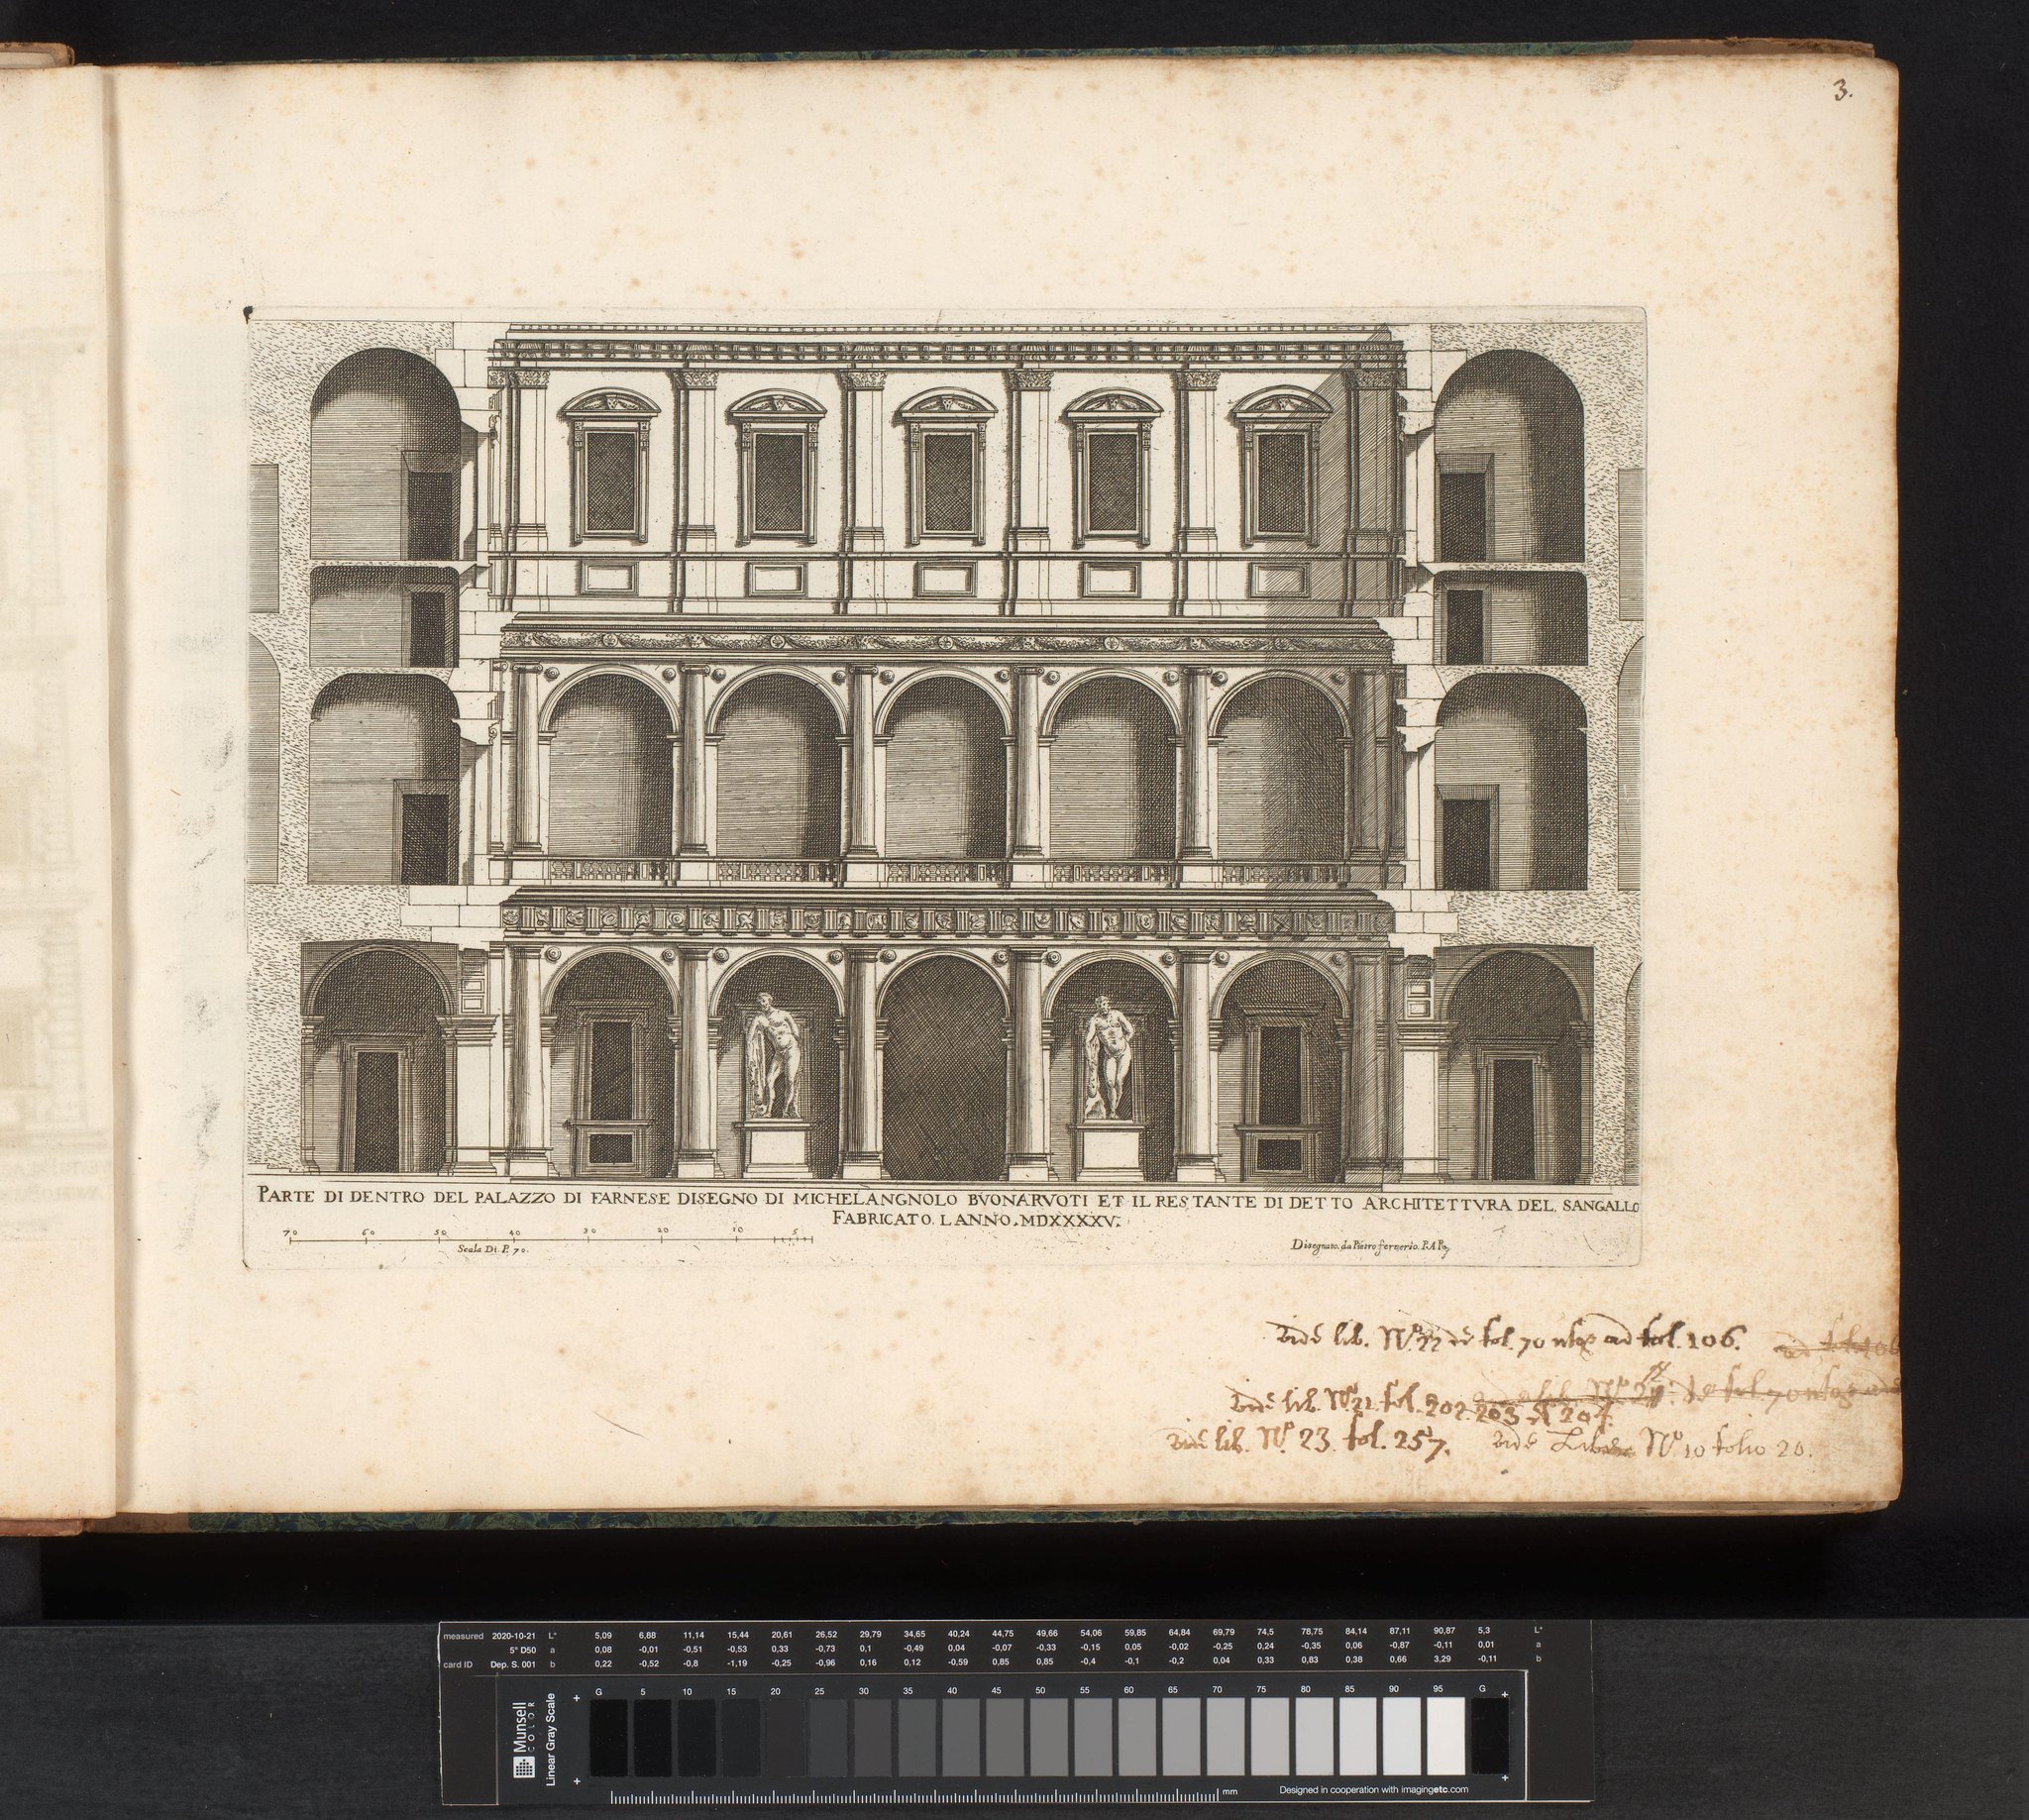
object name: album leaf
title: Façade van de binnenplaats van Palazzo Farnese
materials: paper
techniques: etching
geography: italy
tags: palace, façade (of house or building), inner court of palace or 'hôtel'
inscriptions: number: ‘3’, inscription: ‘Ende lib. No. 22 en fol. 70 [...] fol. 106...’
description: Deze prent maakt deel uit van de reeks getiteld: Palazzi di Roma. Deze reeks bestaat uit twee boeken. Boek één getiteld: Palazzi di Roma dei più celebri architetti..., bestaat uit 44 prenten die worden toegeschreven aan Giovanni Battista Falda (naam staat enkel op prent 27) en uitgegeven door Giovanni Giacomo de'Rossi. Deze 44 prenten zijn bekend in twee staten (met en zonder nummer). Boek twee getiteld: Nuovi disegni dell'architetture... libro secondo, bevat 66 prenten door Giovanni Battista Falda en Simone Felice. Deze 66 prenten zijn bekend in twee staten (met en zonder nummer).